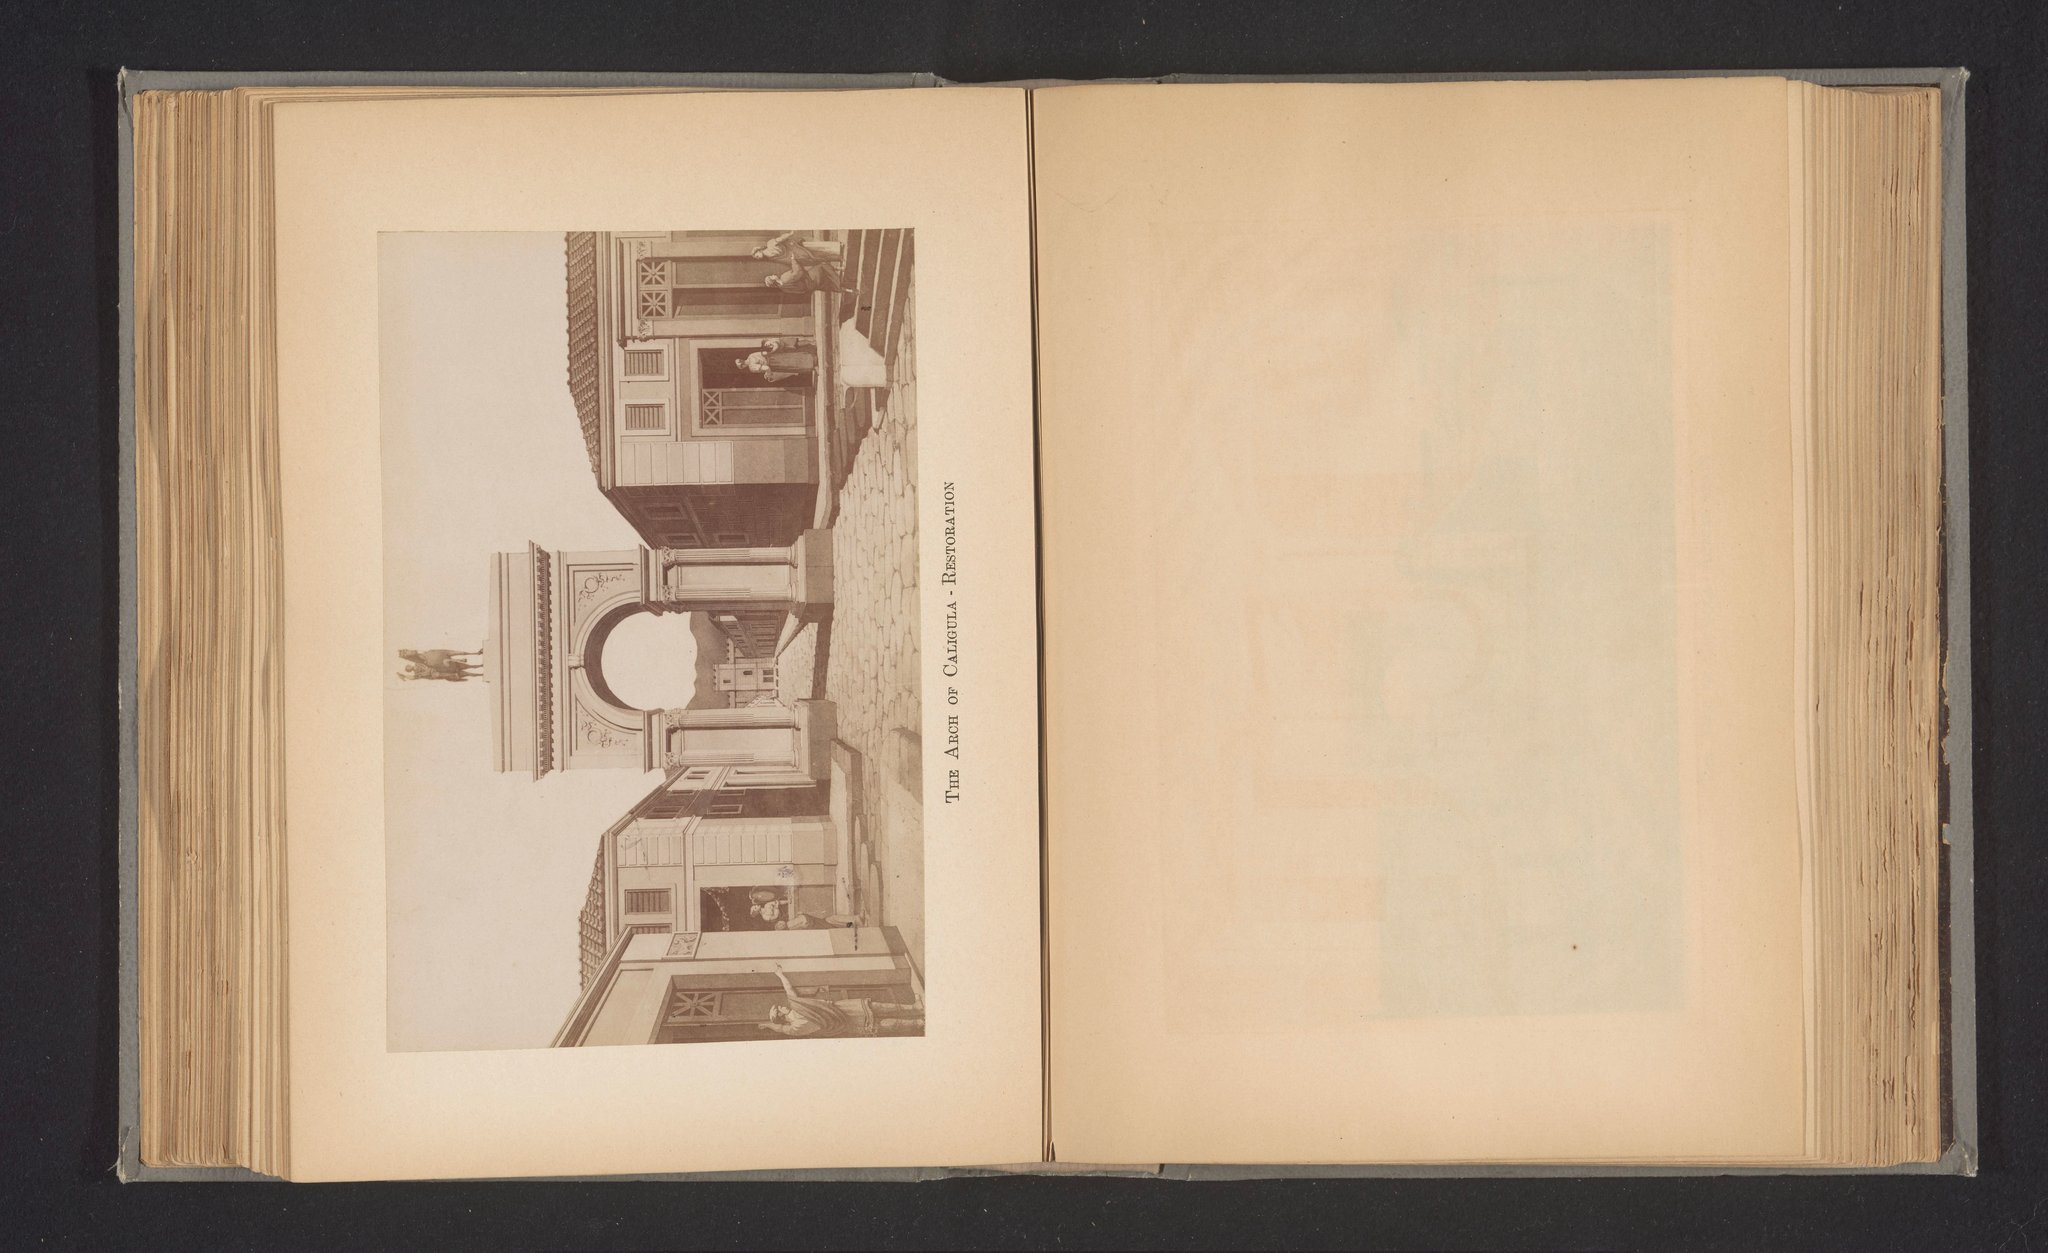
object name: reproduction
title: Fotoreproductie van een gezicht op de boog van Caligula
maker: Anonymous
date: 1890-1895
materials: photographic support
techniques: albumen print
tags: arch, archivolt ~ architecture, pompeii